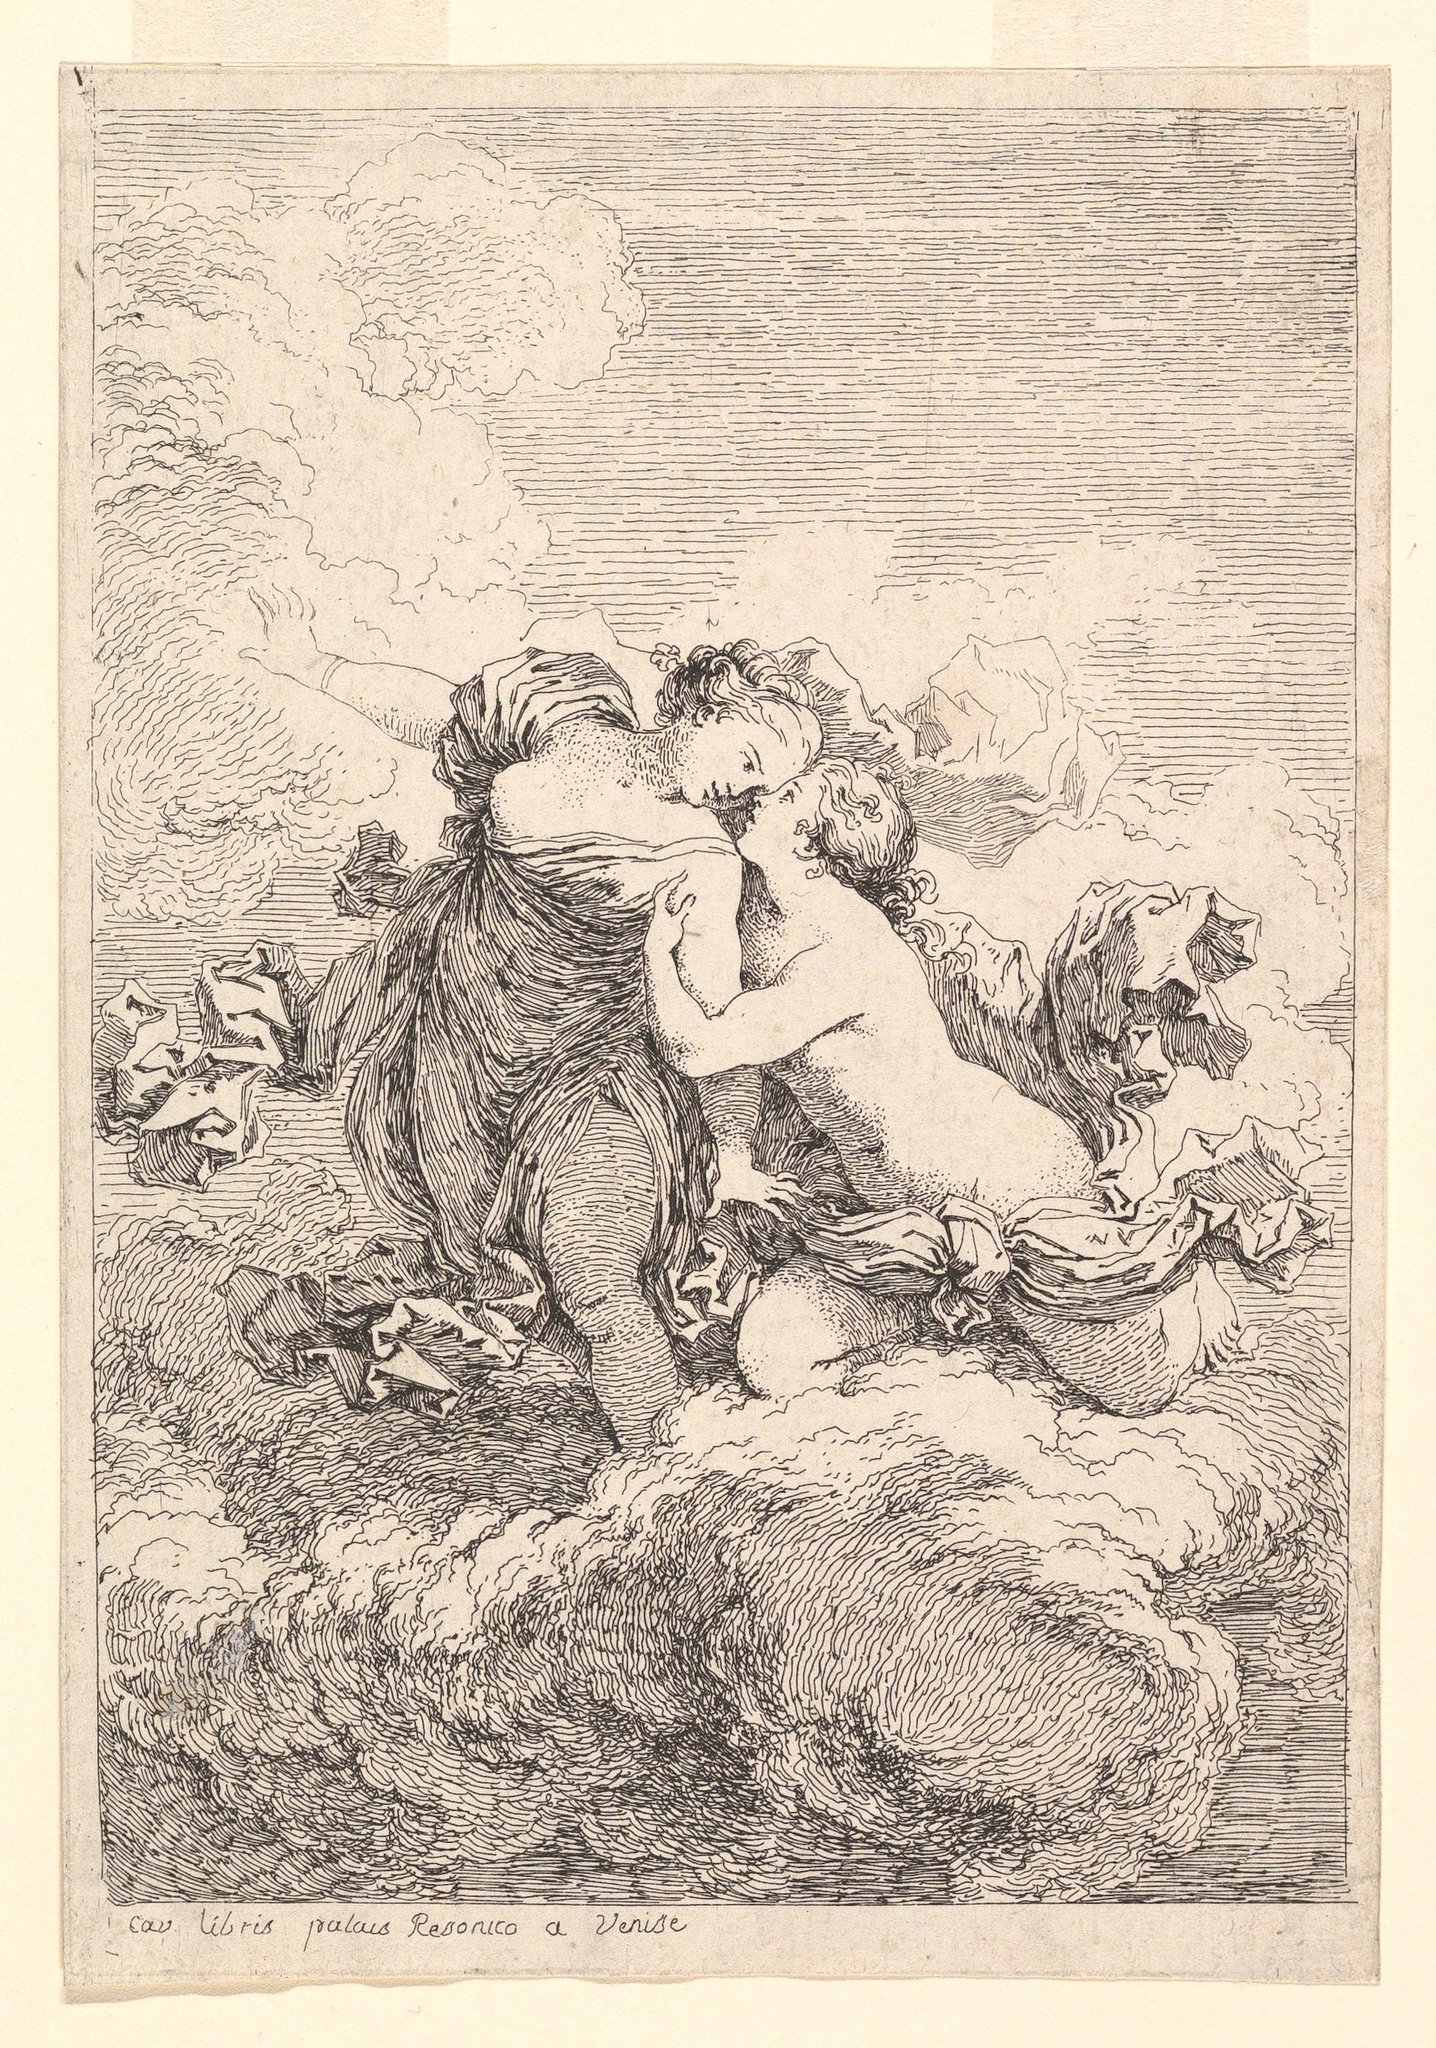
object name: print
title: Mythological Scene, possibly Diana Seducing Callisto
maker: jean honoré fragonard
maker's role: artist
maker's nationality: french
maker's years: 1732-1806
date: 1764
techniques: etching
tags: women,diana